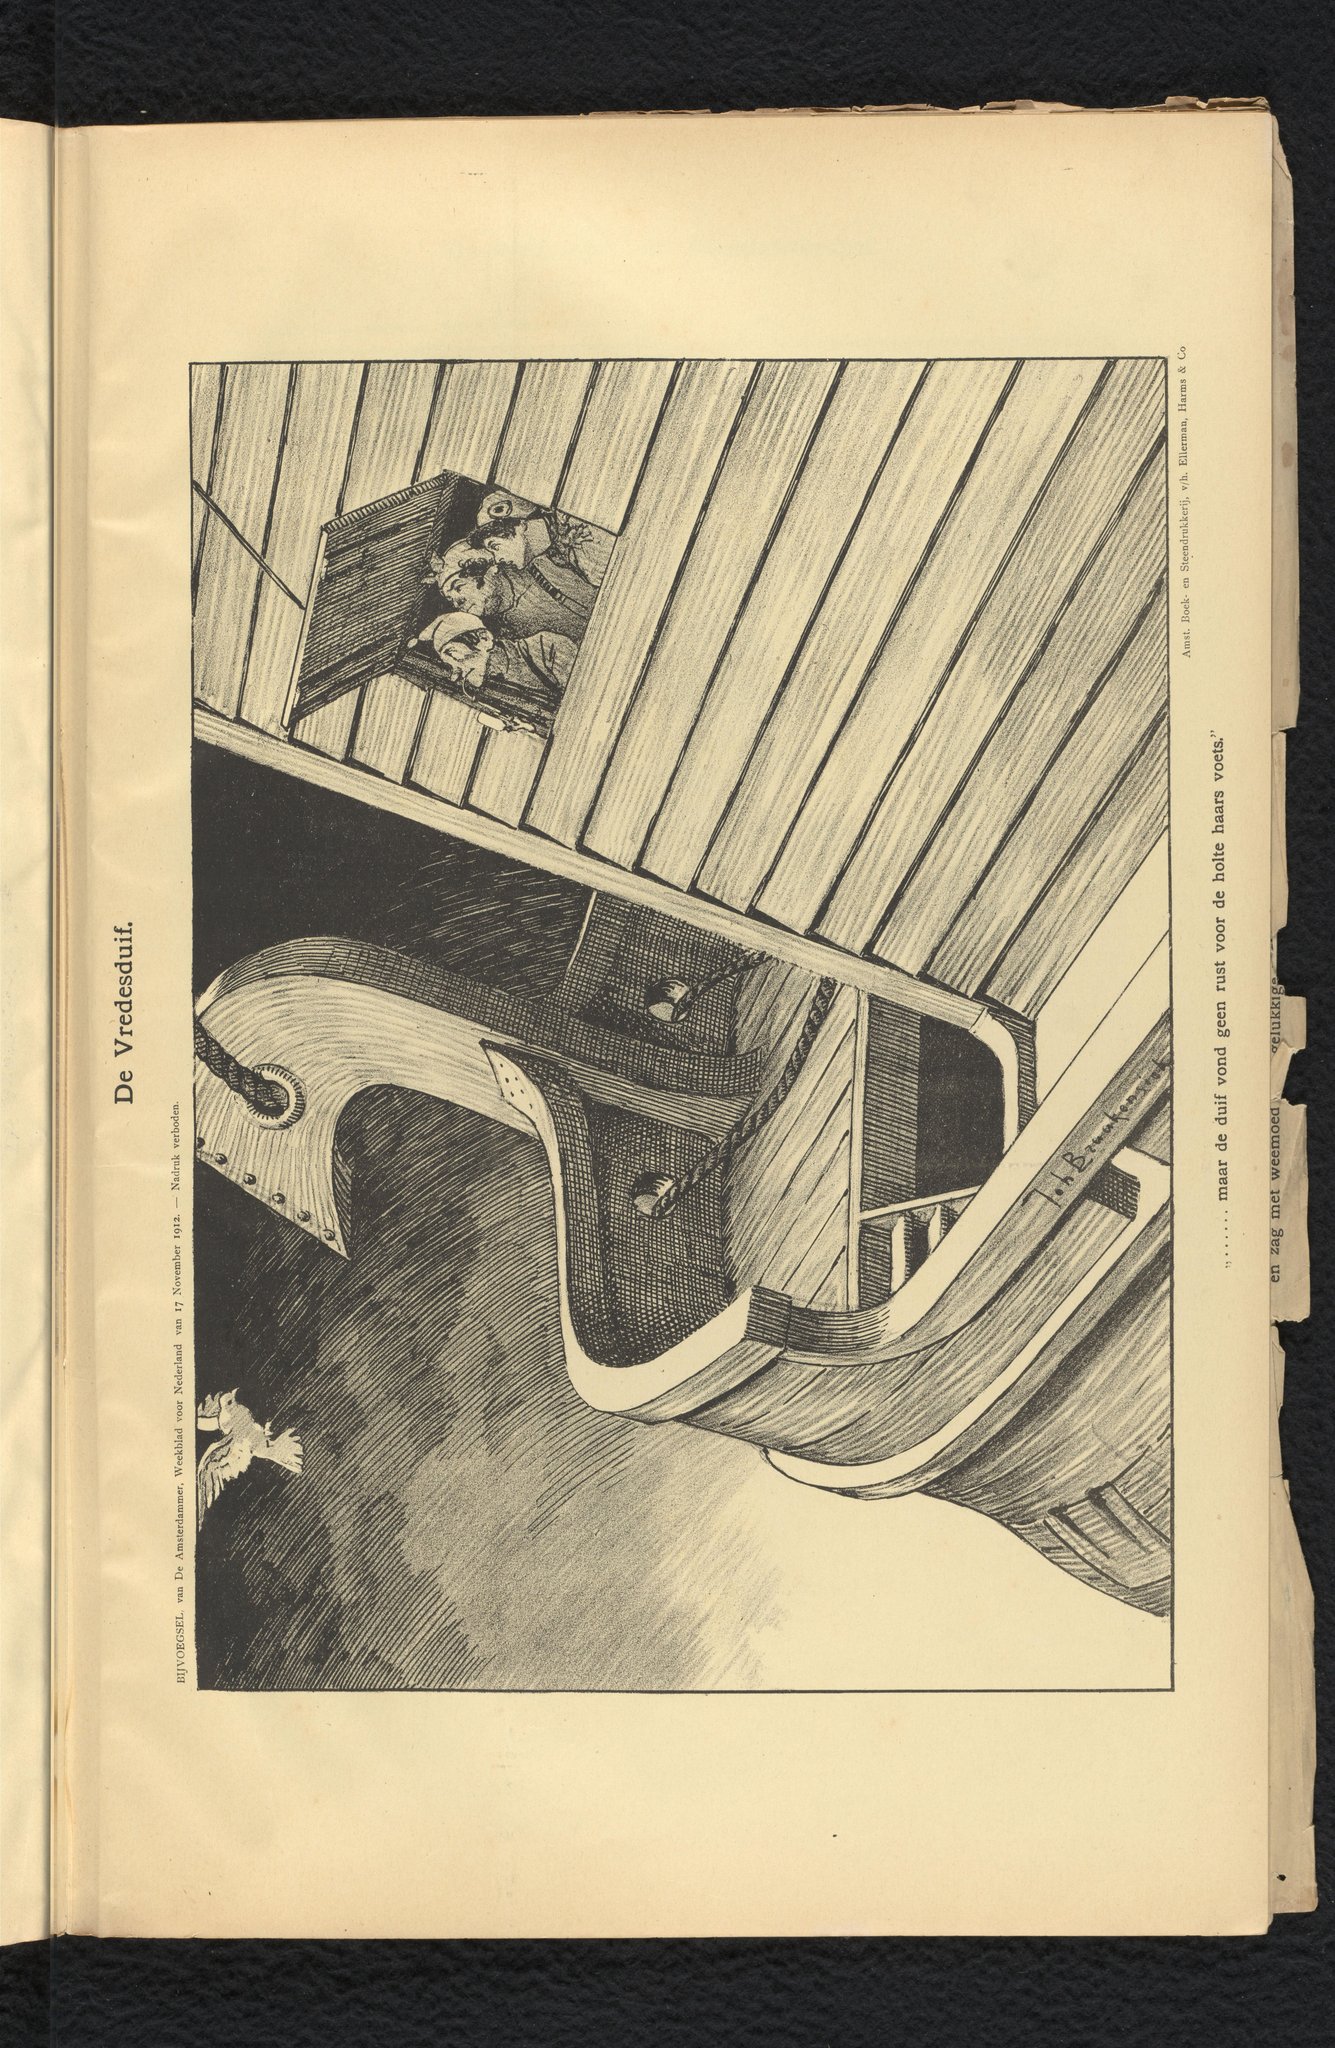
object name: cartoon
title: De Vredesduif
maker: johan braakensiek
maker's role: draughtsman, print maker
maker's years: 1858-1940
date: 1912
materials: paper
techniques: lithograph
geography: netherlands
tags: personifications of countries, nations, states, districts, etc., symbols, allegories of peace, 'pax'; 'pace' (ripa), noah sends off a dove, political caricatures and satires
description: Michel (Duitsland), John Bull (Engeland) en Marianne (Frankrijk) kijken uit een luik in de ark van Noach naar de terugkeer van de (vredes)duif. Naar aanleiding van het uitblijven van de vrede in Europa.